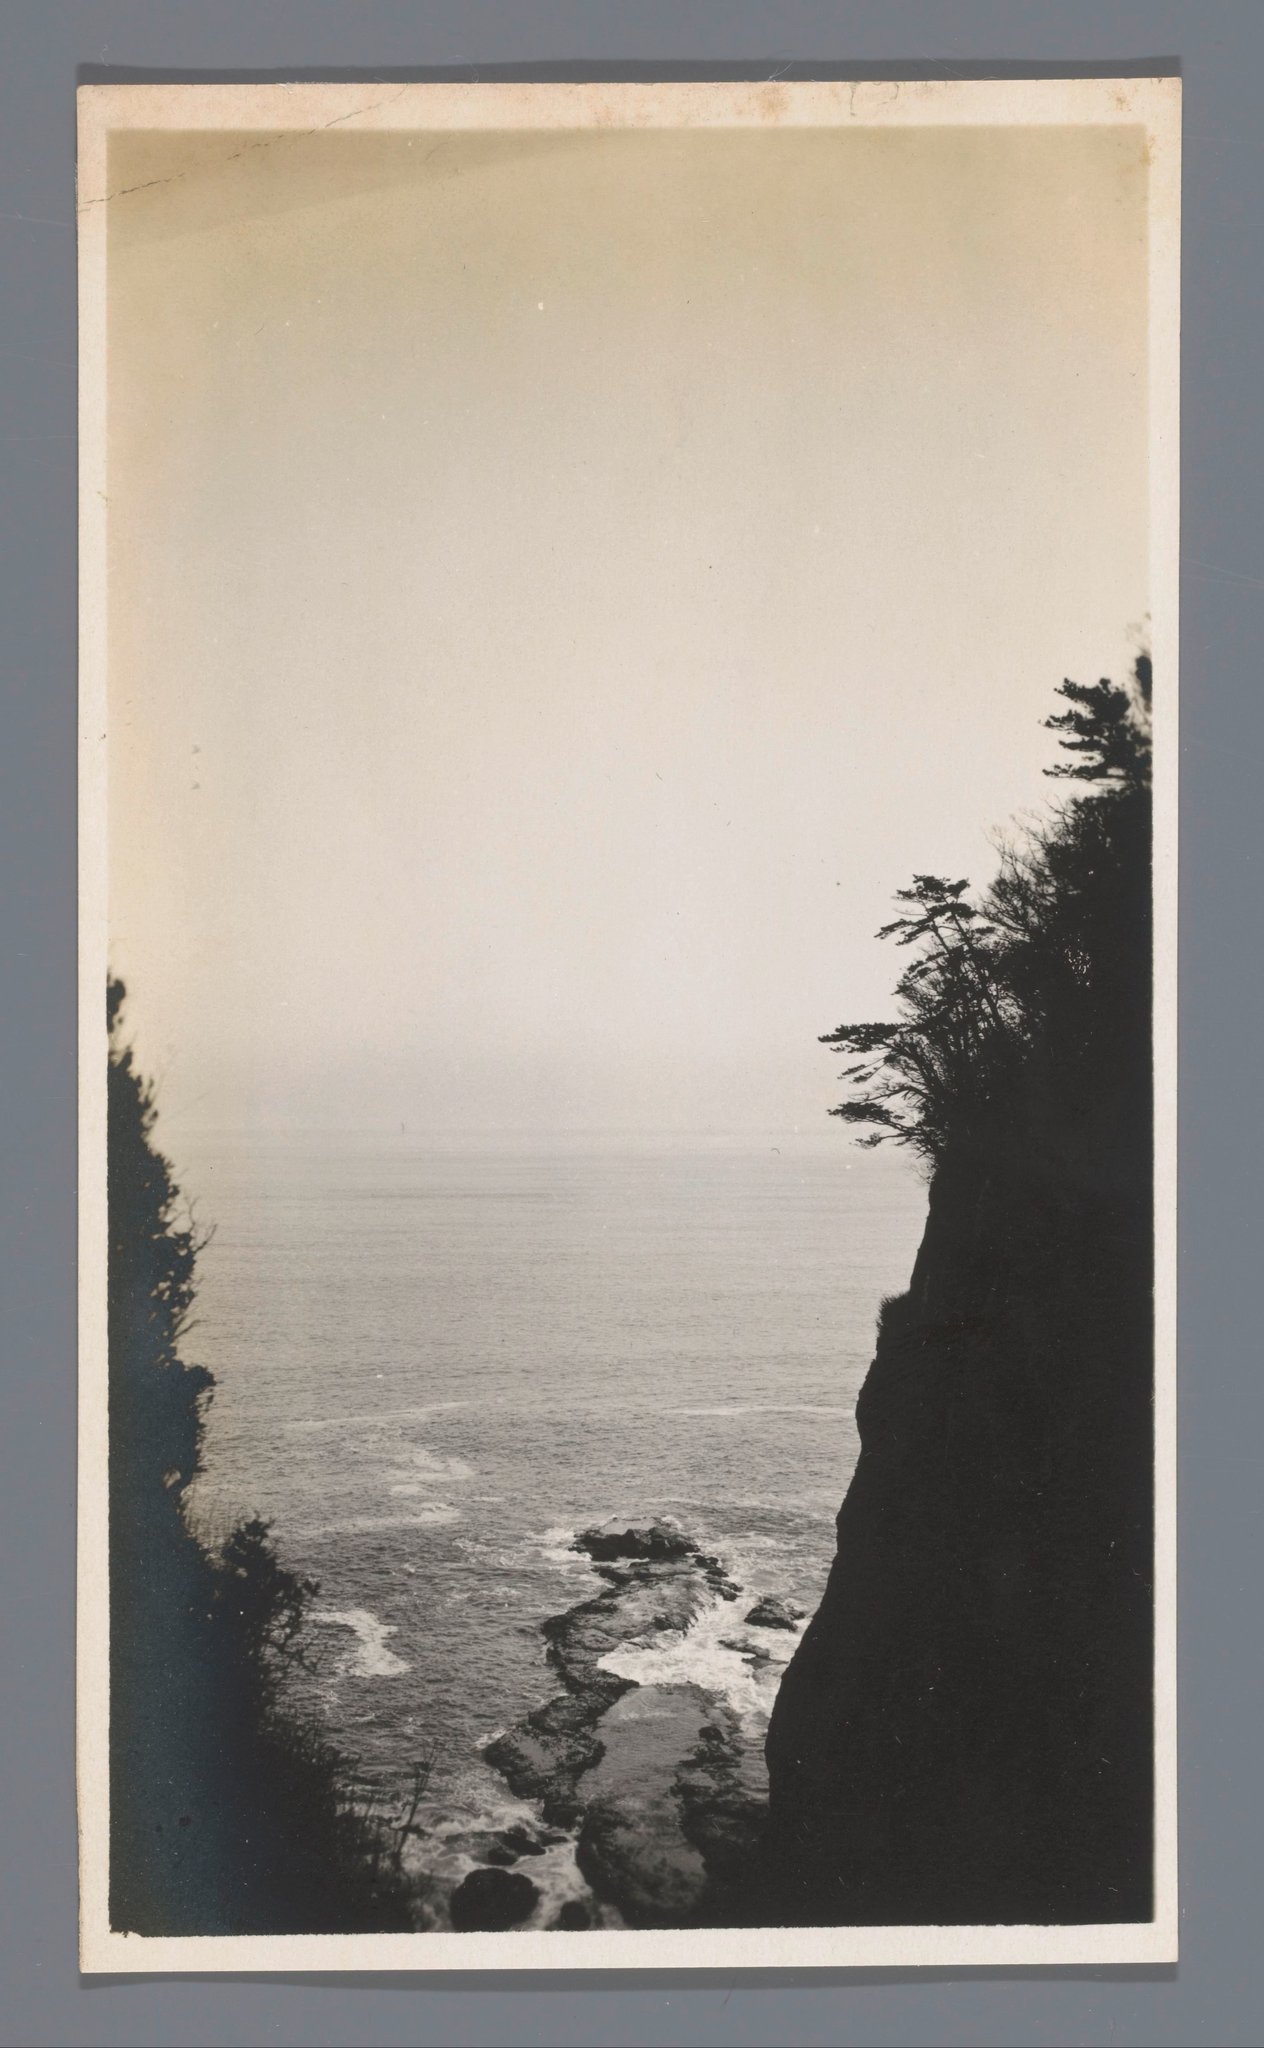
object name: photograph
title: Zeegezicht met steile rotsen op de voorgrond, Japan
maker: jan adriani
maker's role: fotograaf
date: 1907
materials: paper, photographic support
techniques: gelatin silver print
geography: japan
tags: sea (seascape)